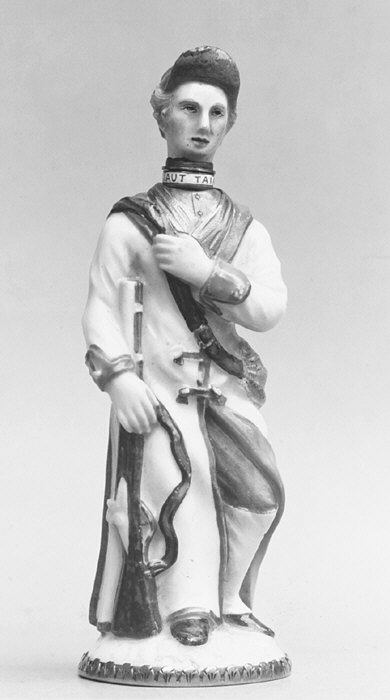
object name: scent bottle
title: Scent bottle in the form of a hunter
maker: meissen manufactory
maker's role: manufactory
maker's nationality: german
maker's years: 1710-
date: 1740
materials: porcelain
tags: firearms,men